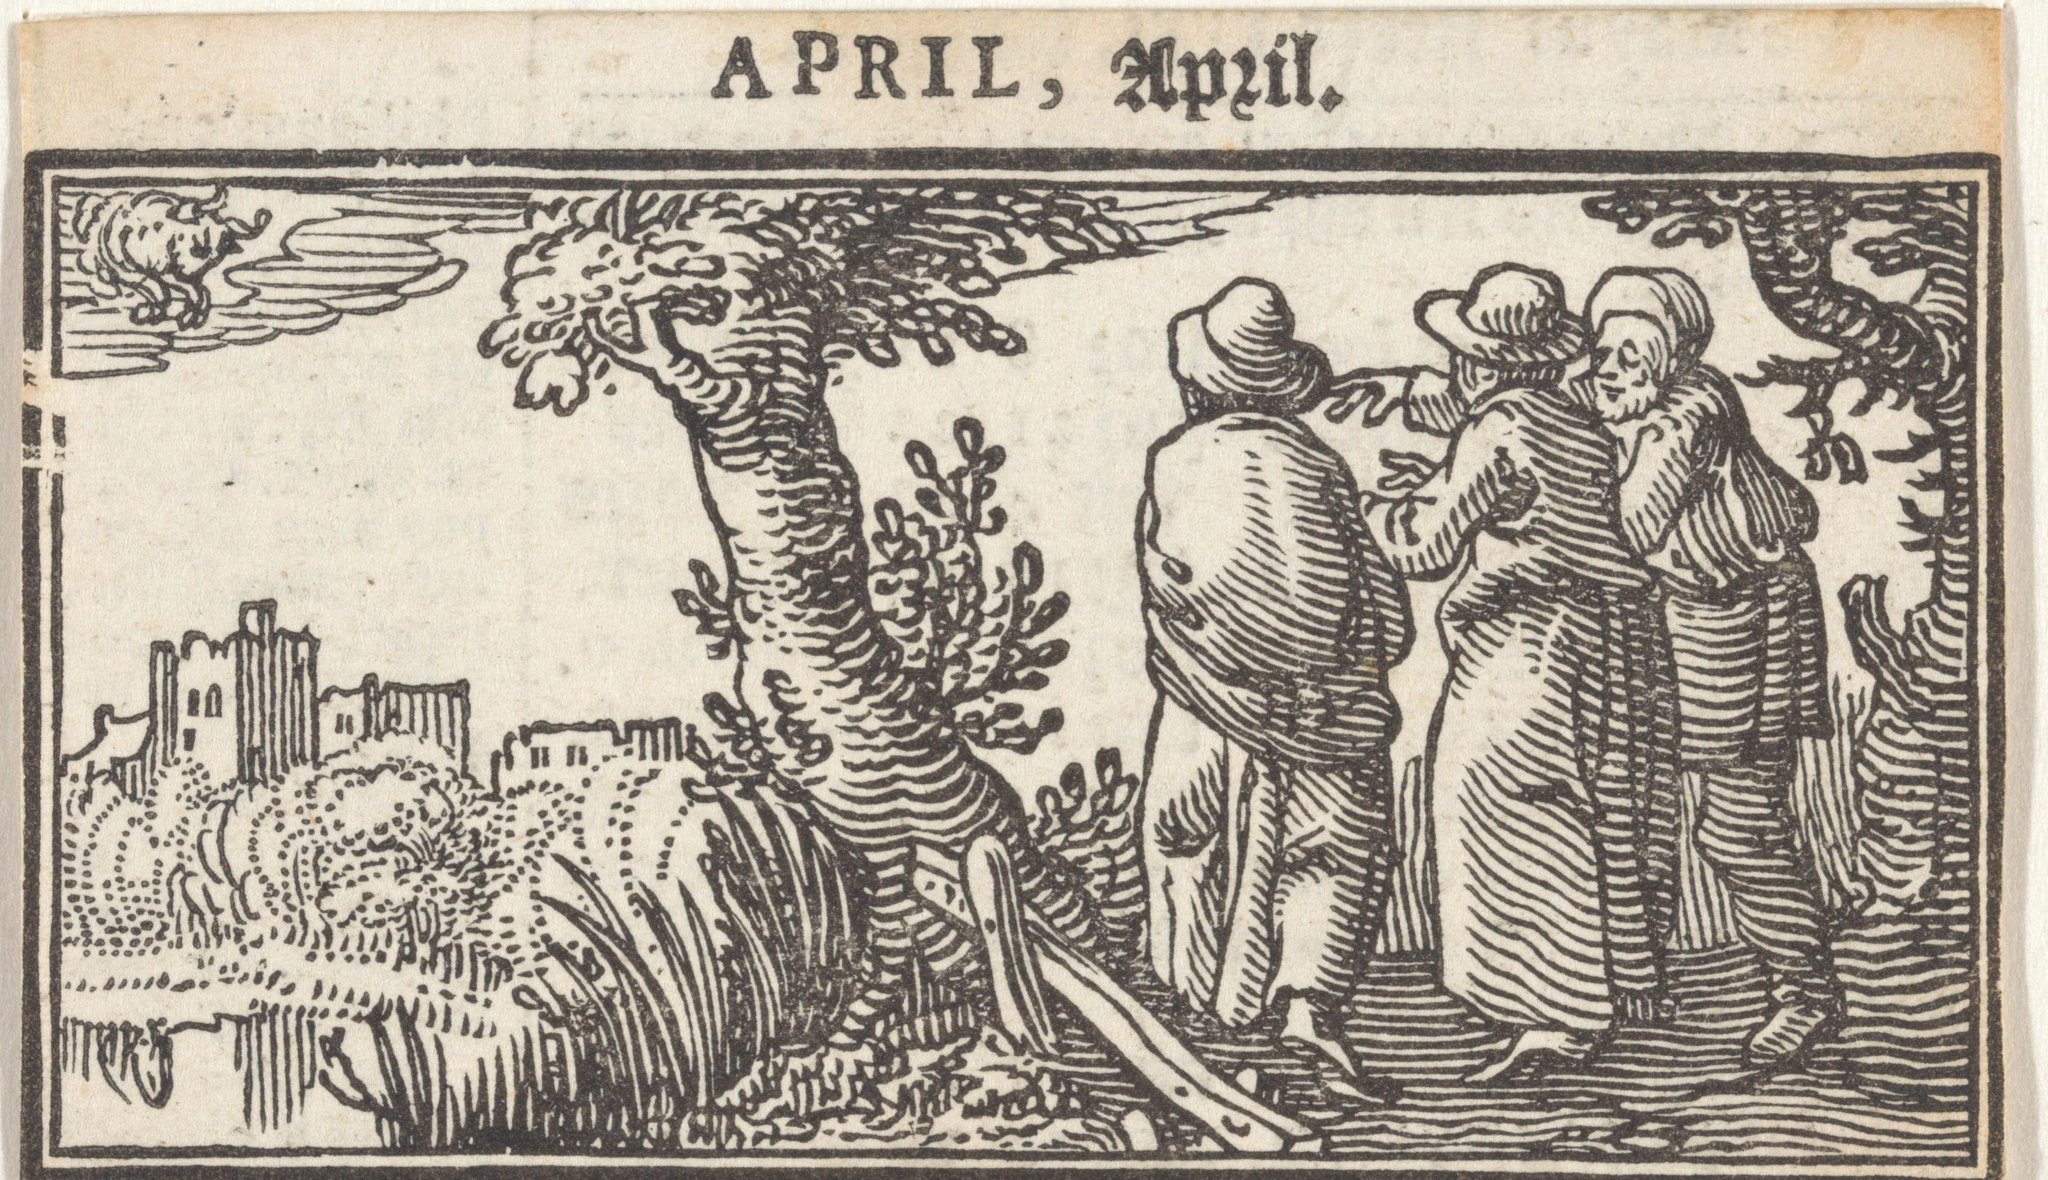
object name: book illustration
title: Emmaüsgangers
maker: Anonymous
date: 1600-1699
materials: paper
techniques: letterpress printing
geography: netherlands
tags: cleopas and peter meet christ (sometimes they are dressed as pilgrims)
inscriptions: collector's mark: Lugt 2228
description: Christus loopt samen met twee discipelen naar het dorp Emmaüs.